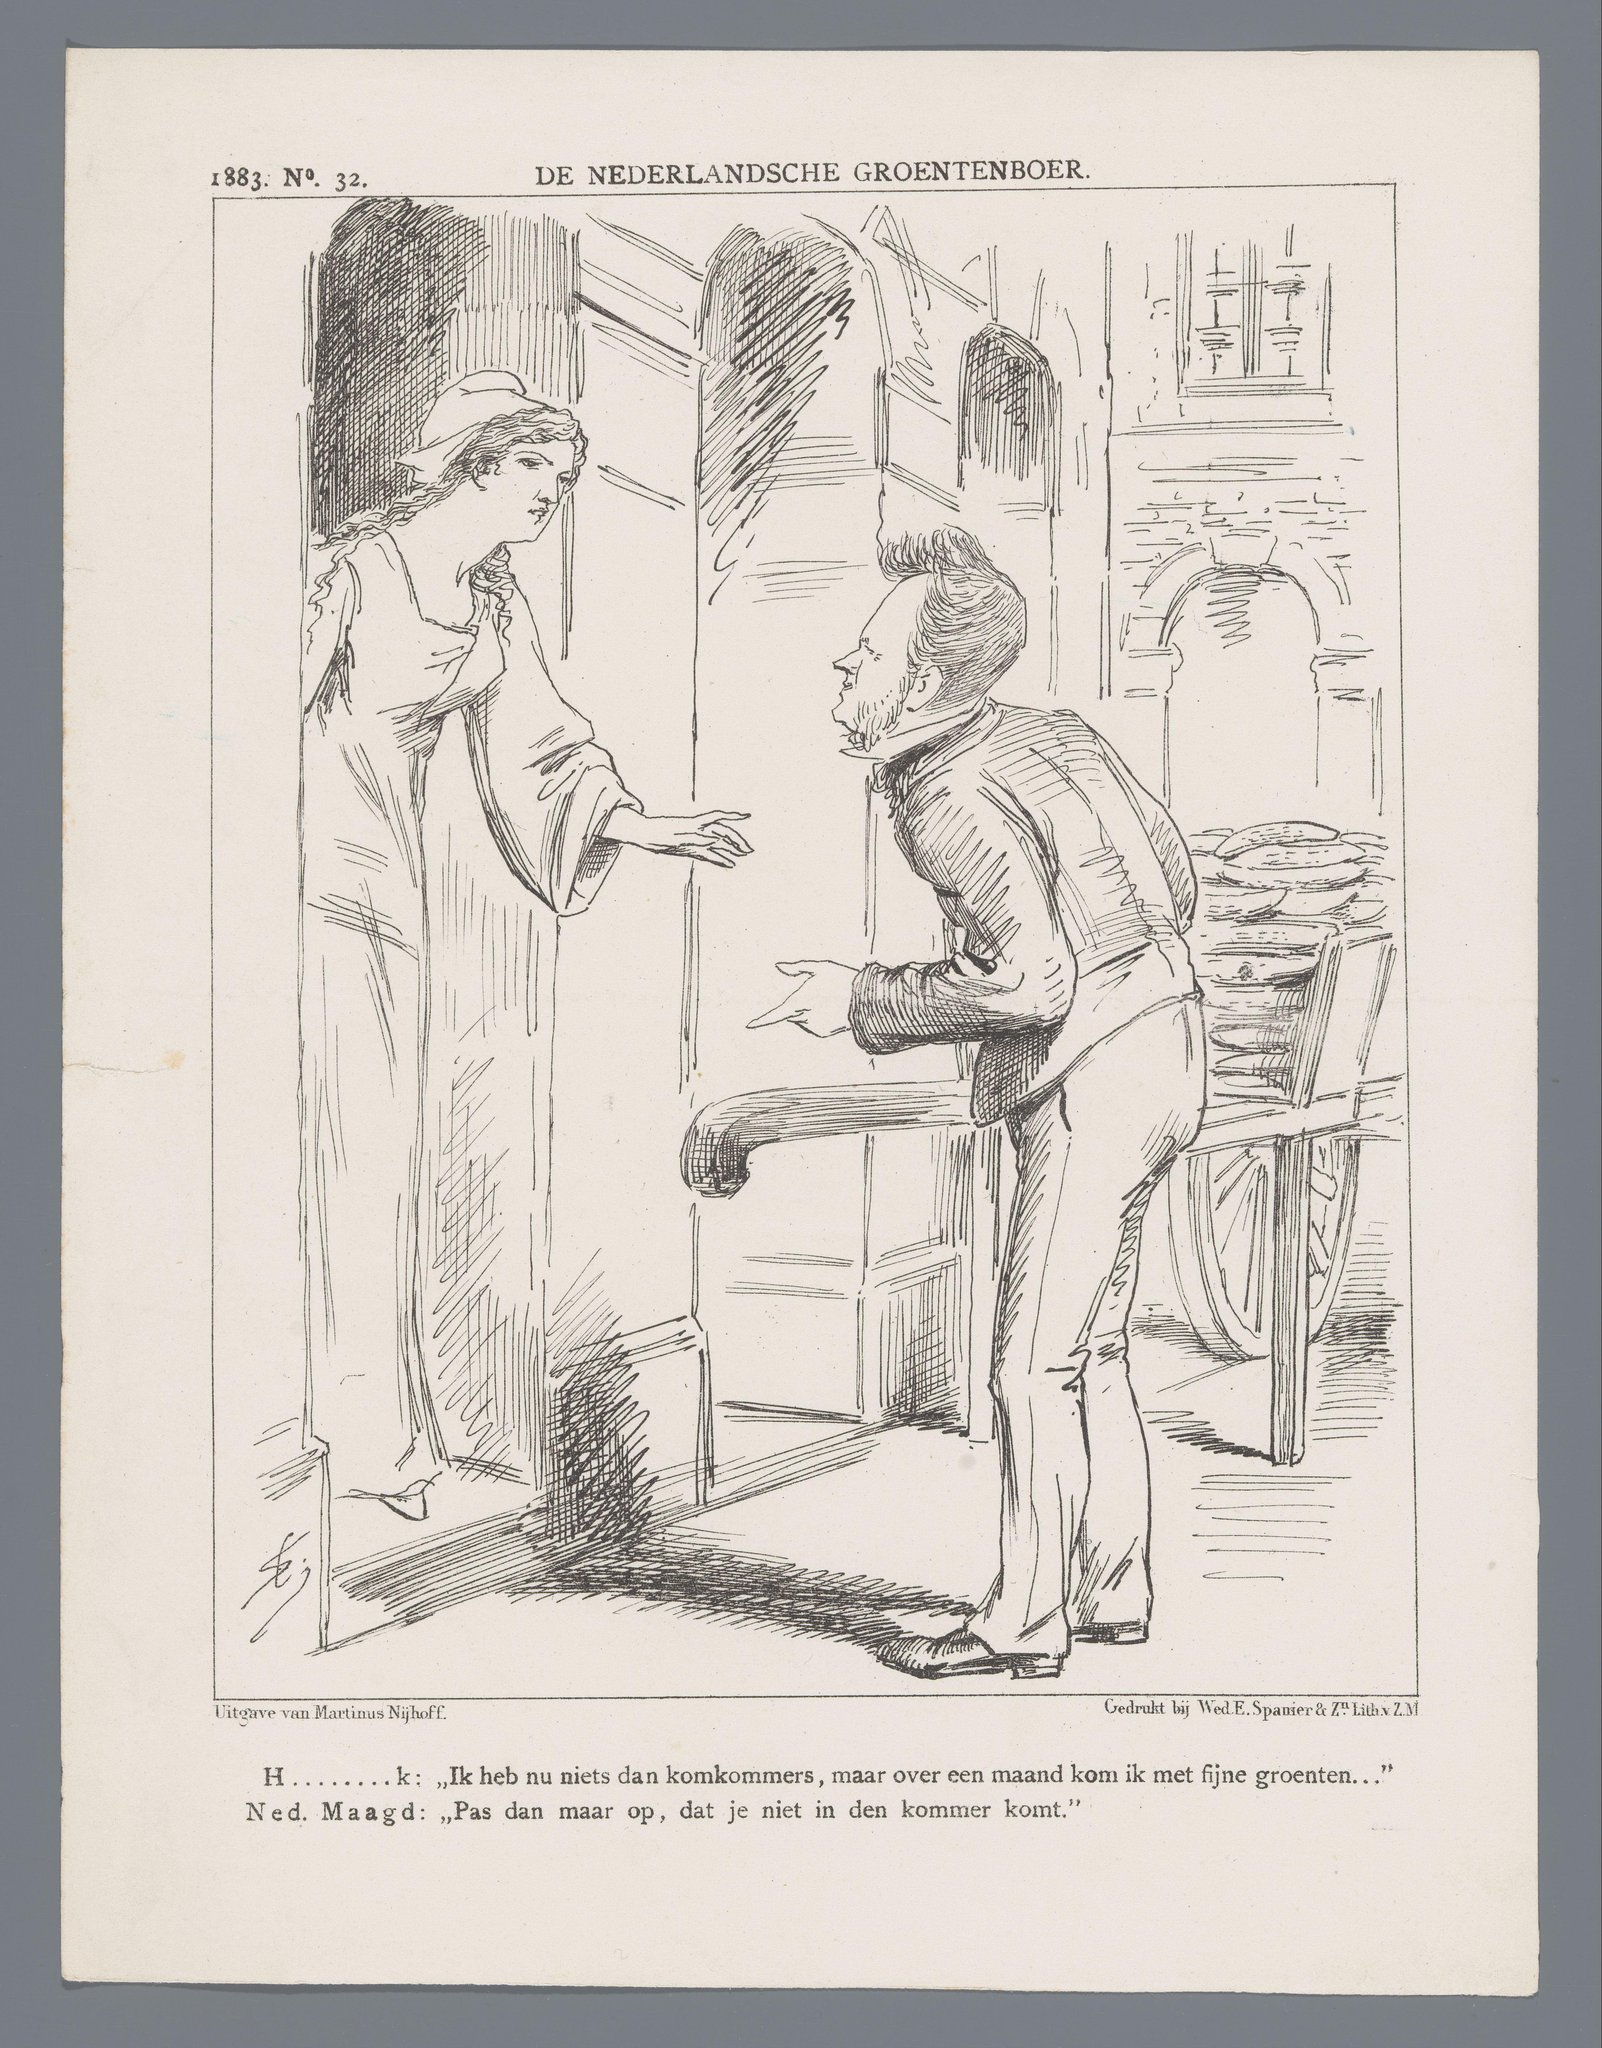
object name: print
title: De Nederlandsche groentenboer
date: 1883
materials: paper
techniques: lithograph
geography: netherlands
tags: politician, personifications of countries, nations, states, districts, etc.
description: Spotprent met Heemskerk die als groenteboer met komkommers aanbelt bij de Nederlandse Maagd. Plaat verschenen bij het weekblad De Nederlandsche Spectator, nr. 32, 1883.